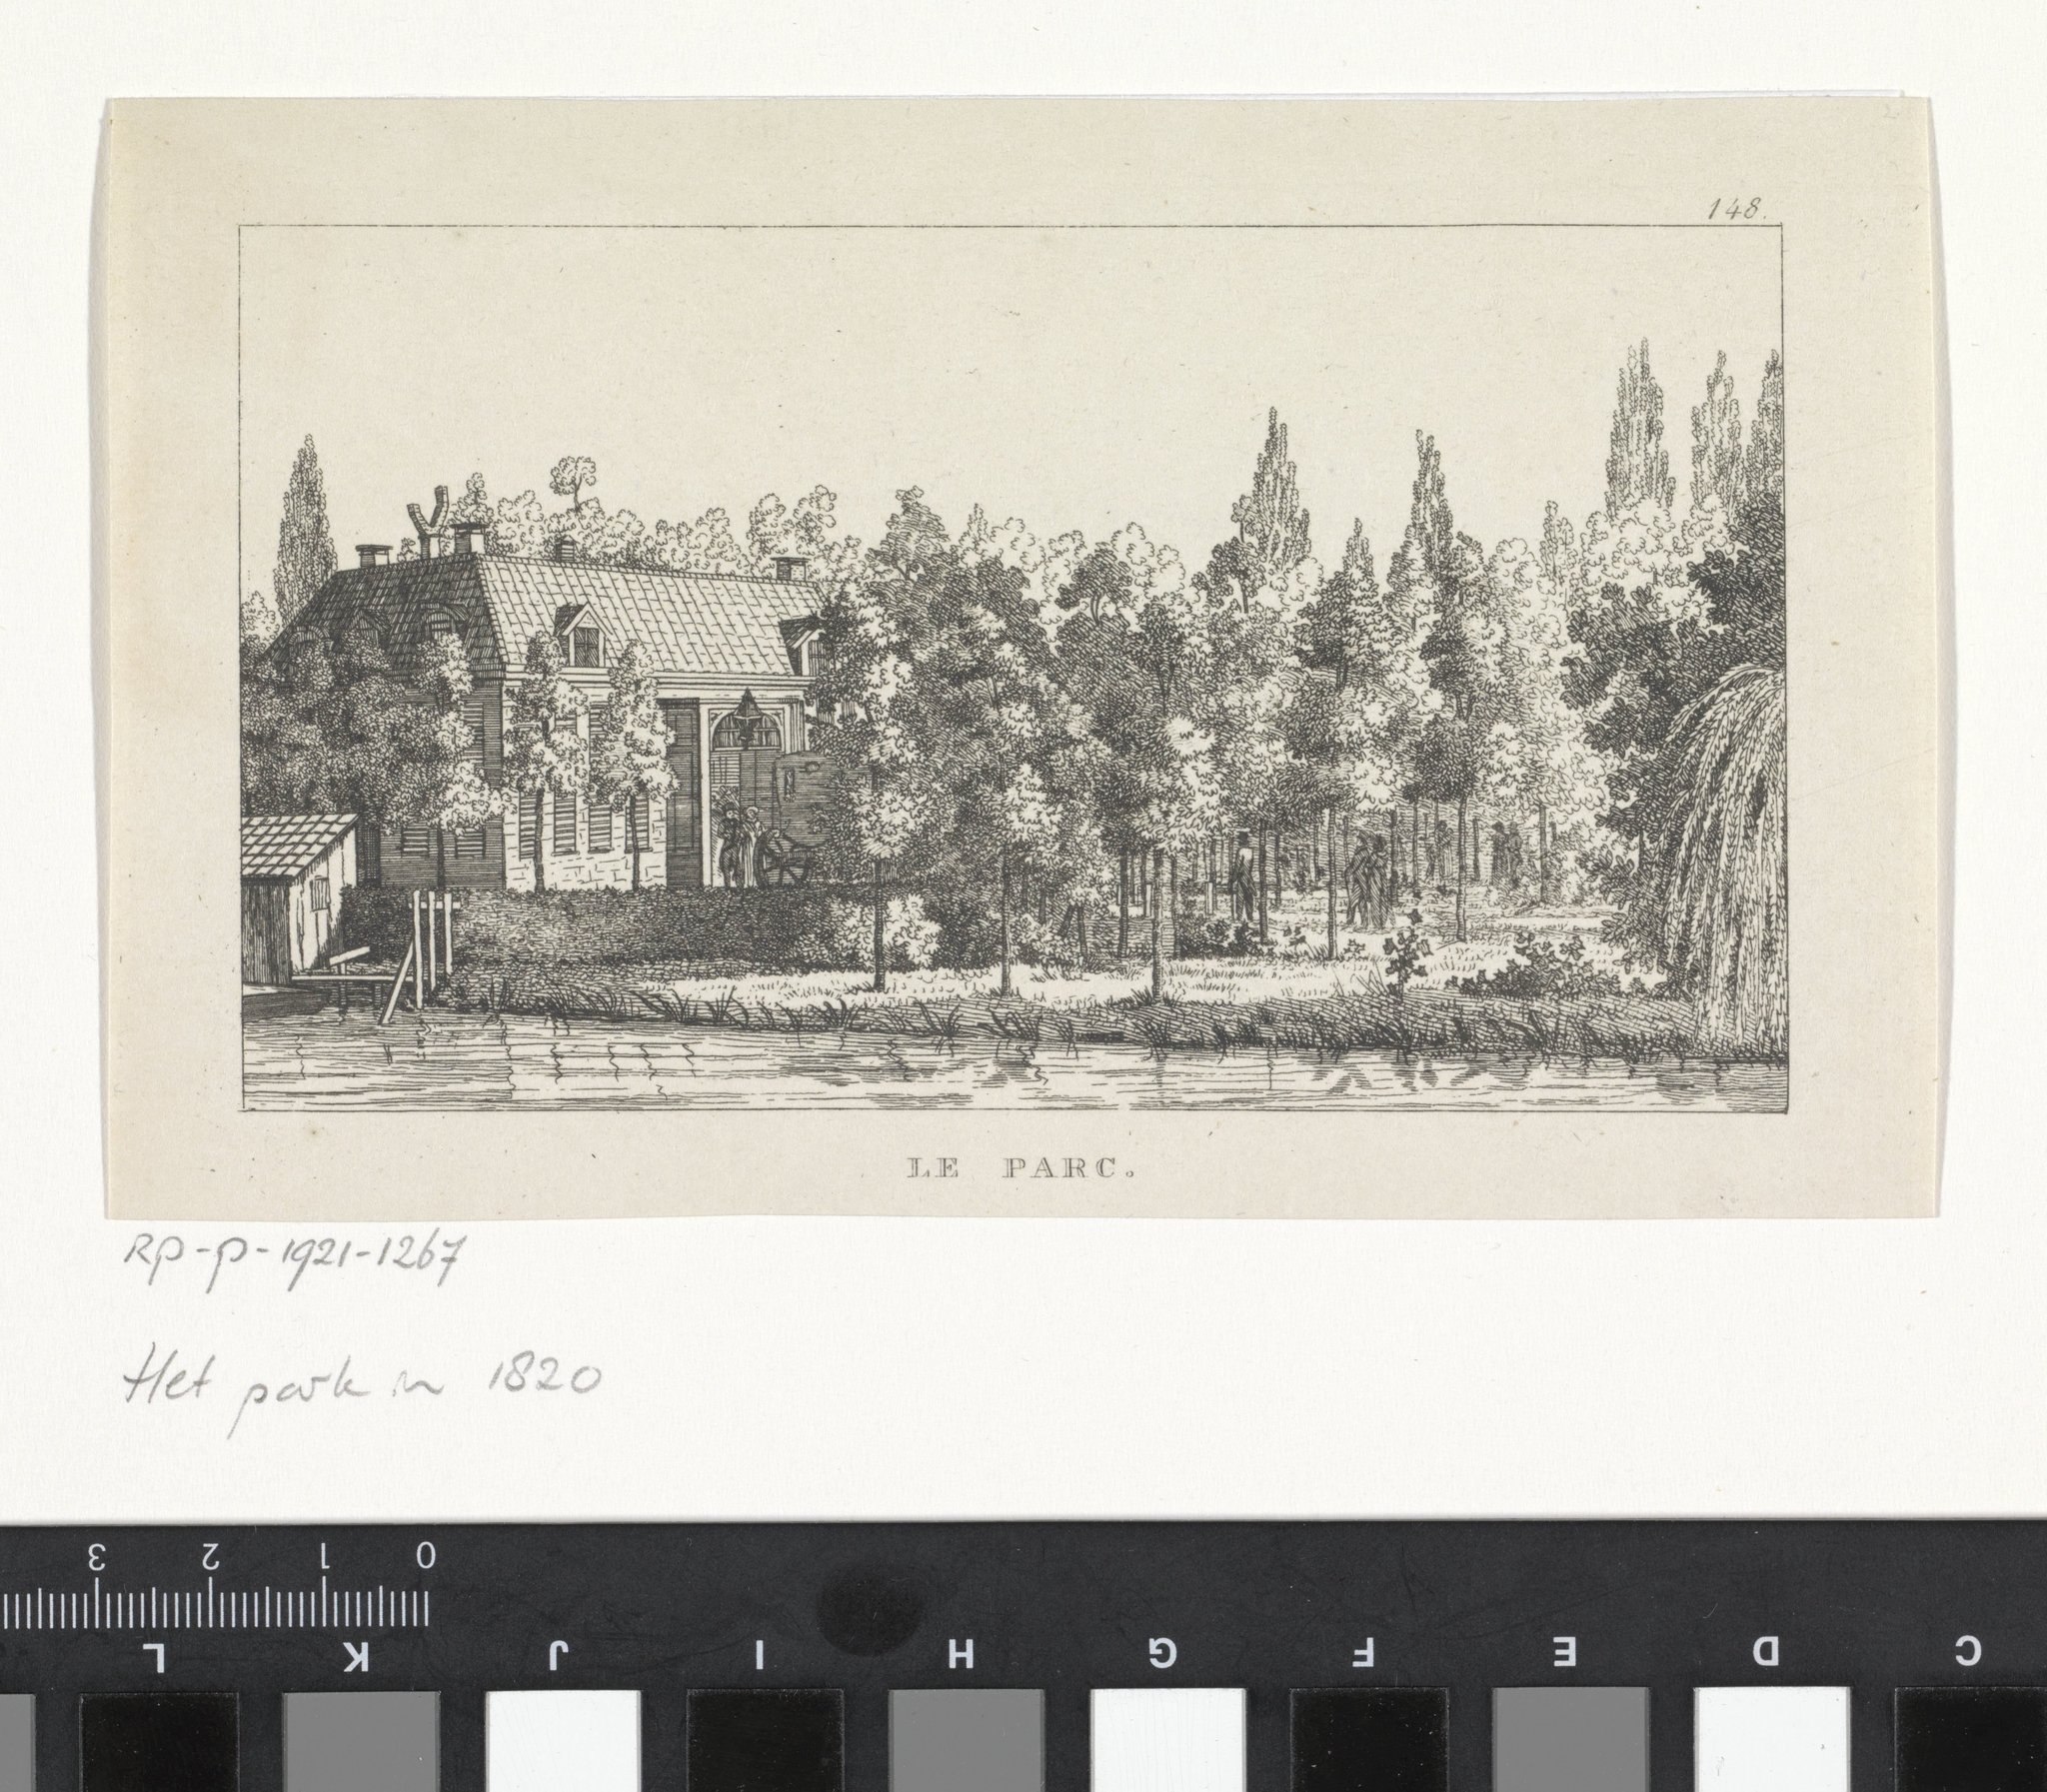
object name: print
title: Le Parc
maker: Anonymous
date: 1820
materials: paper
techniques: etching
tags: park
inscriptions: collector's mark: Lugt 2233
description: Gezicht op een park met wandelaars. Links een huis met een koets ervoor. Op de voorgrond water. Rechtsboven genummerd: 148.